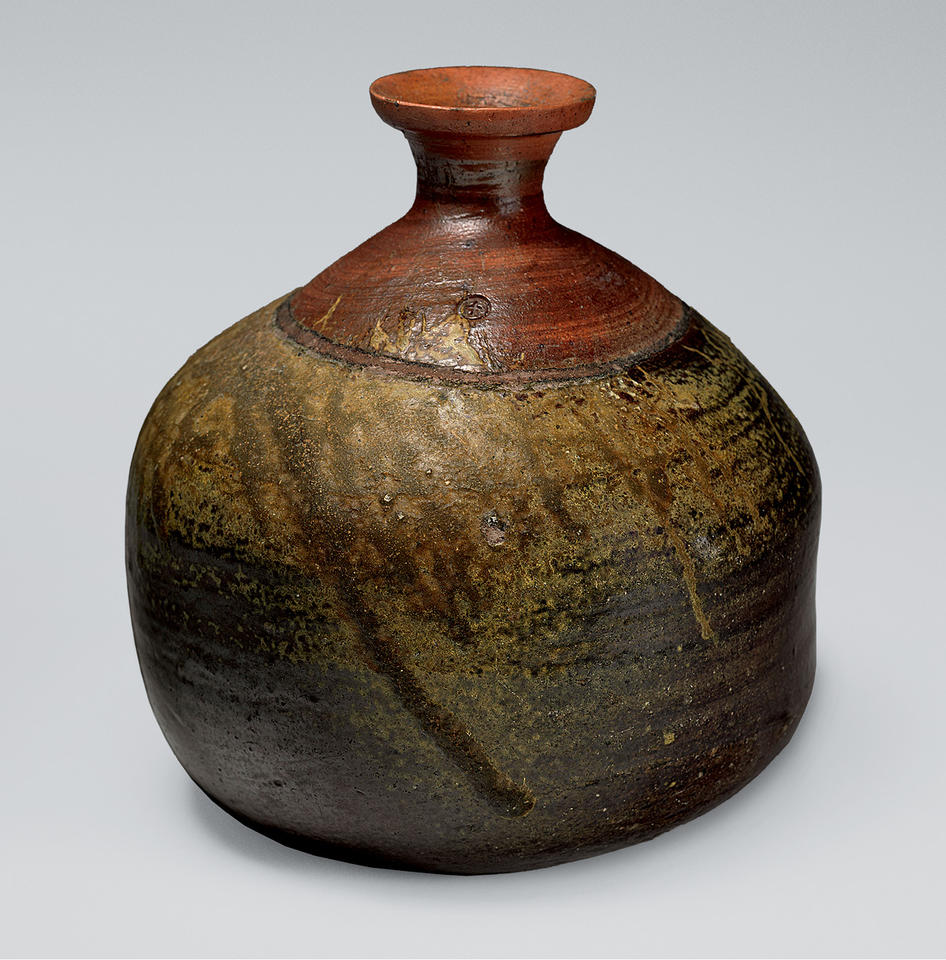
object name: sake bottle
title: Sake Bottle (Tokkuri)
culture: japanese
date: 1567-1633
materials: wood, glaze, stoneware